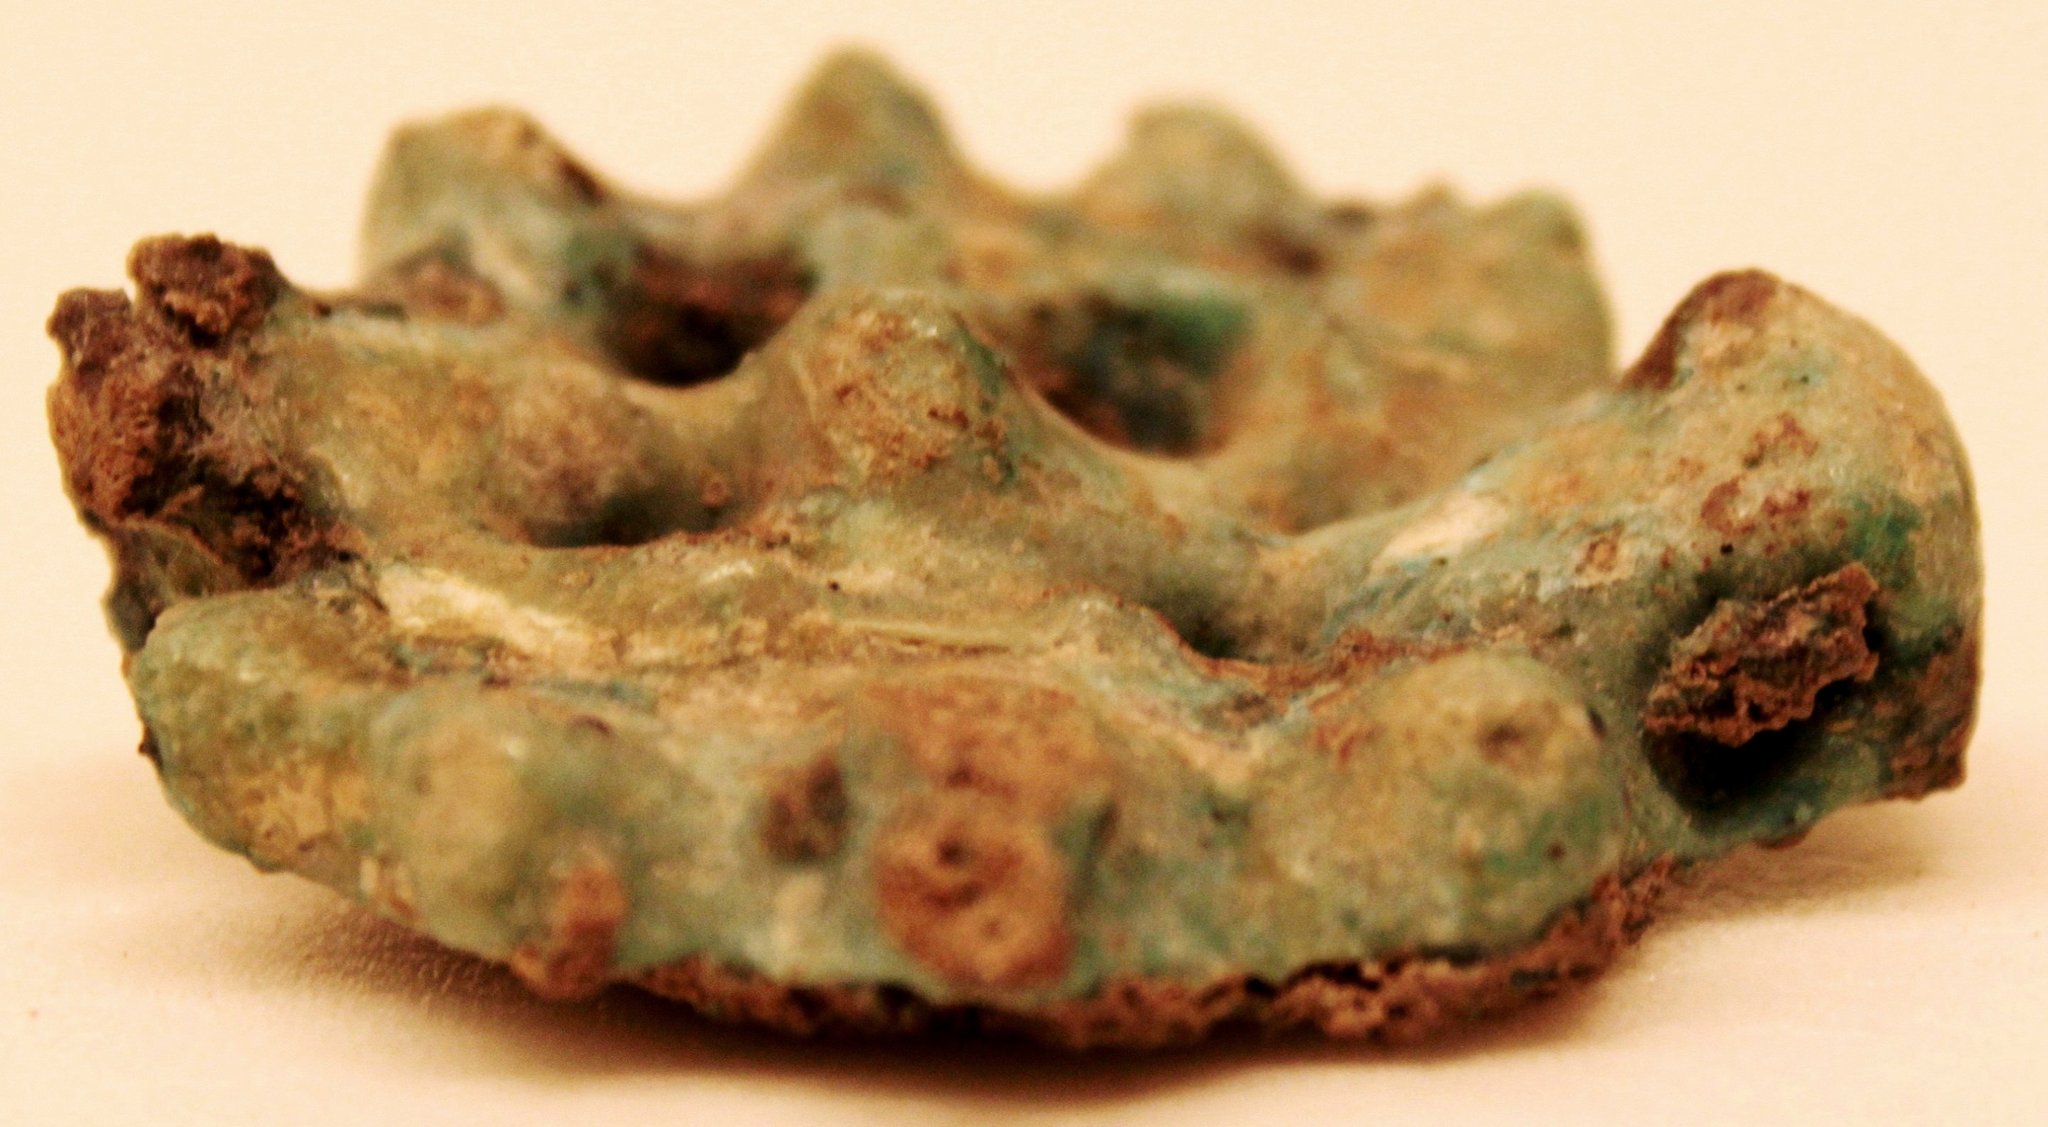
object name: waster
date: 1001-1200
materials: copper, earthenware, glaze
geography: iran